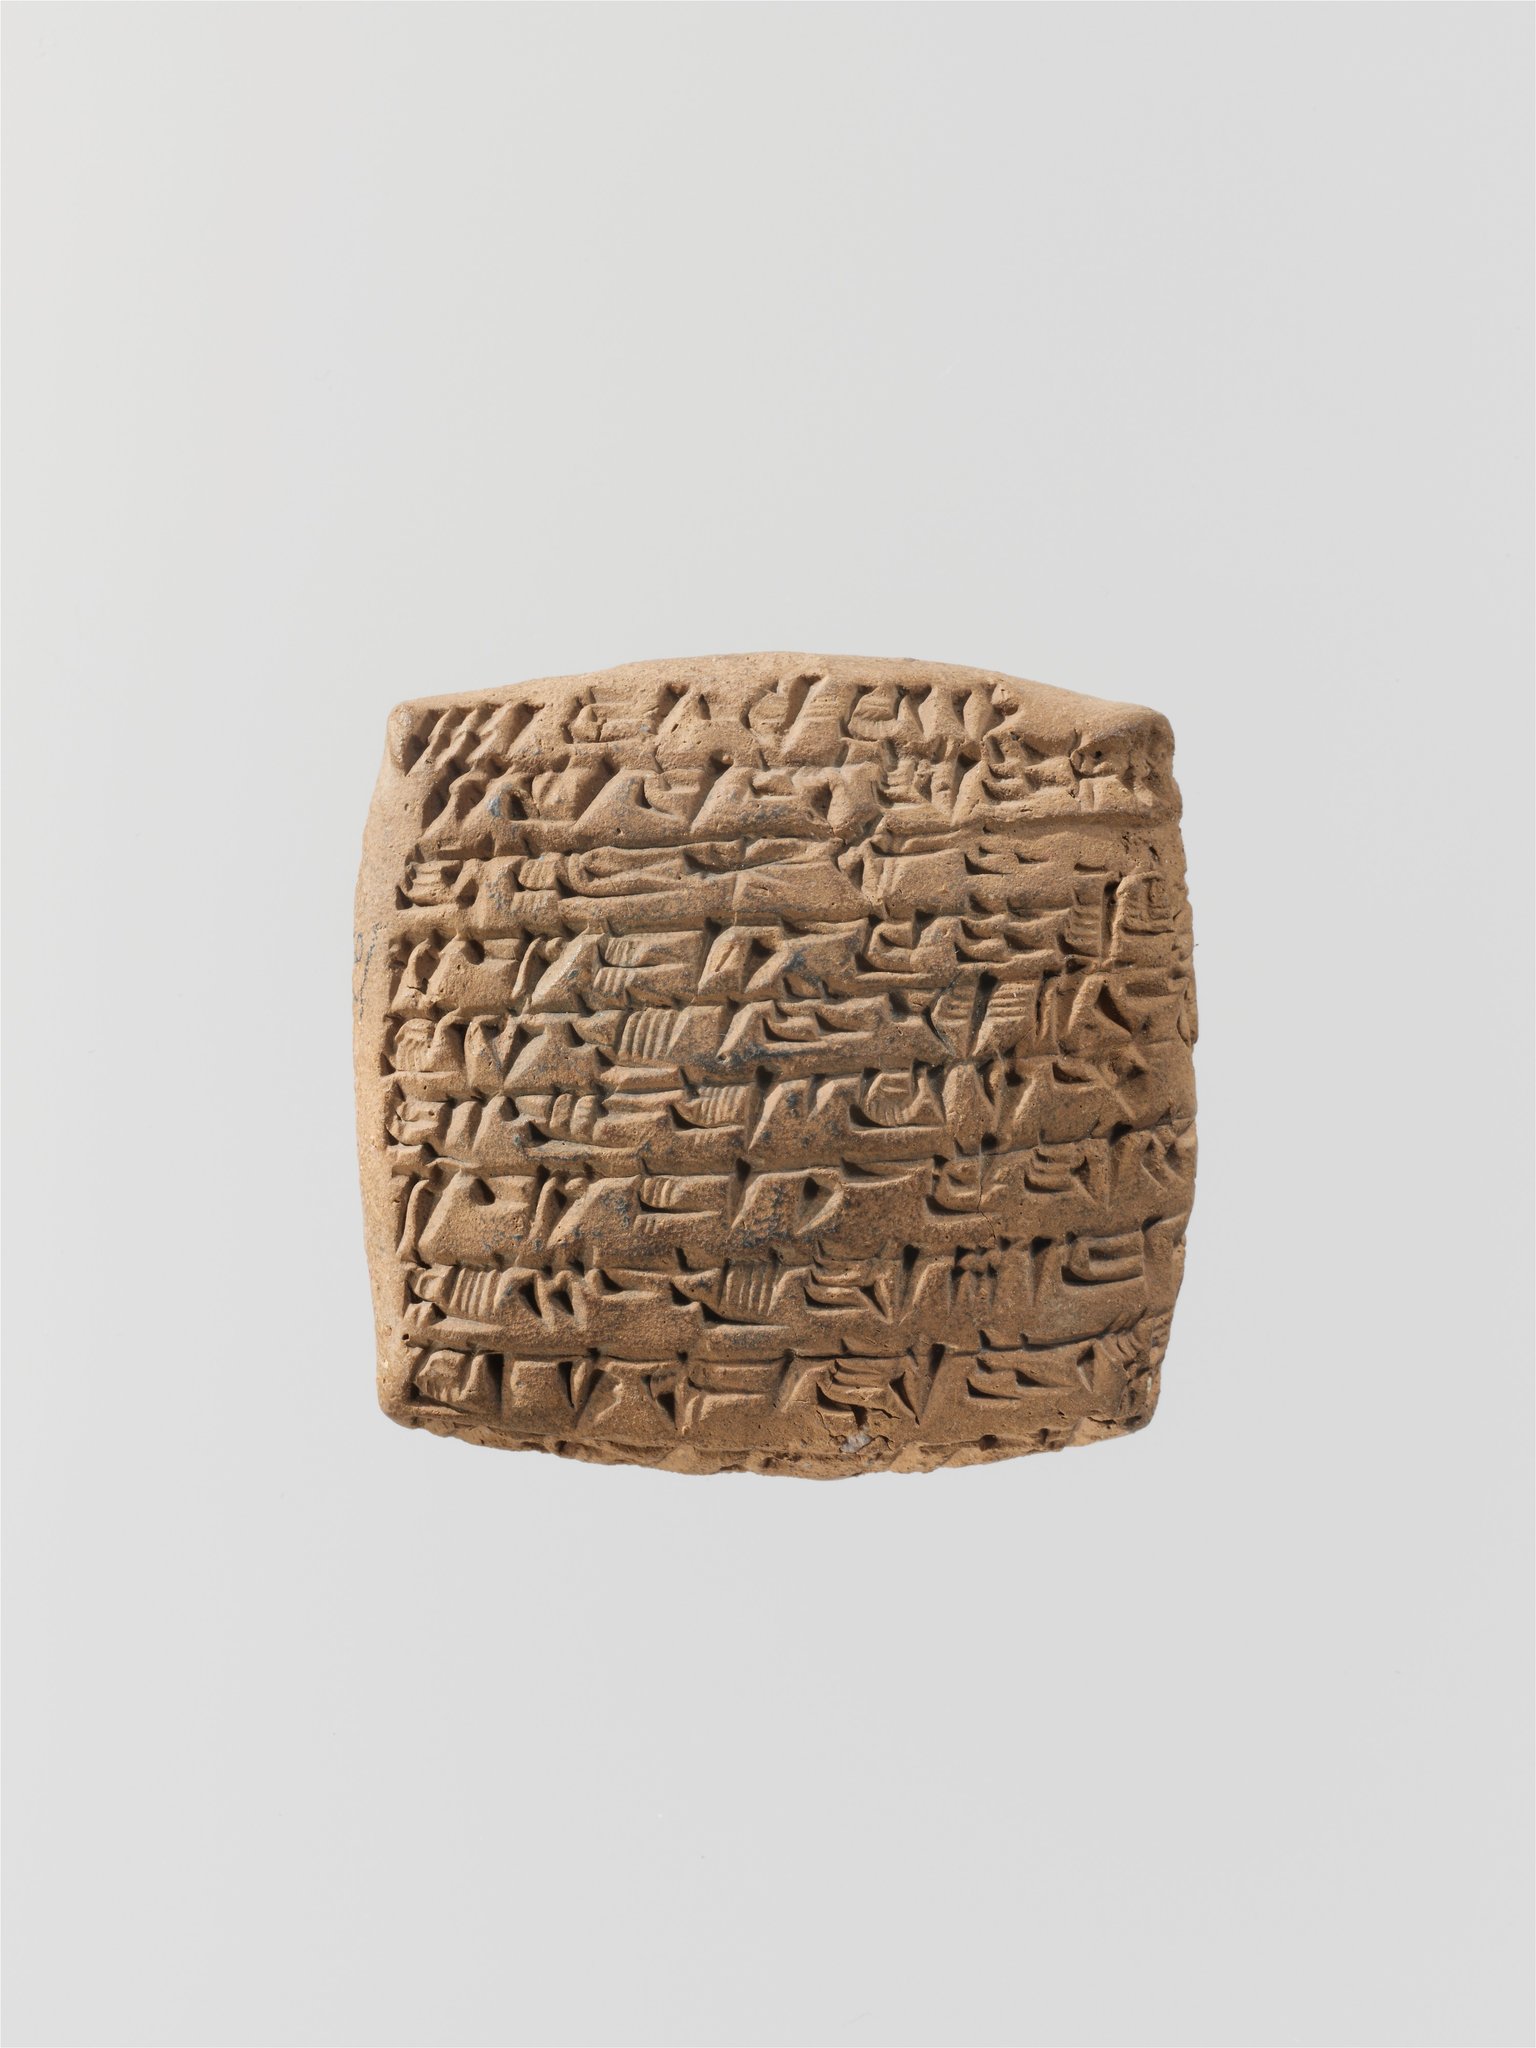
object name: cuneiform tablet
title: Cuneiform tablet: quittance for a loan in silver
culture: assyrian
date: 2000-1801 BCE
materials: clay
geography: anatolia